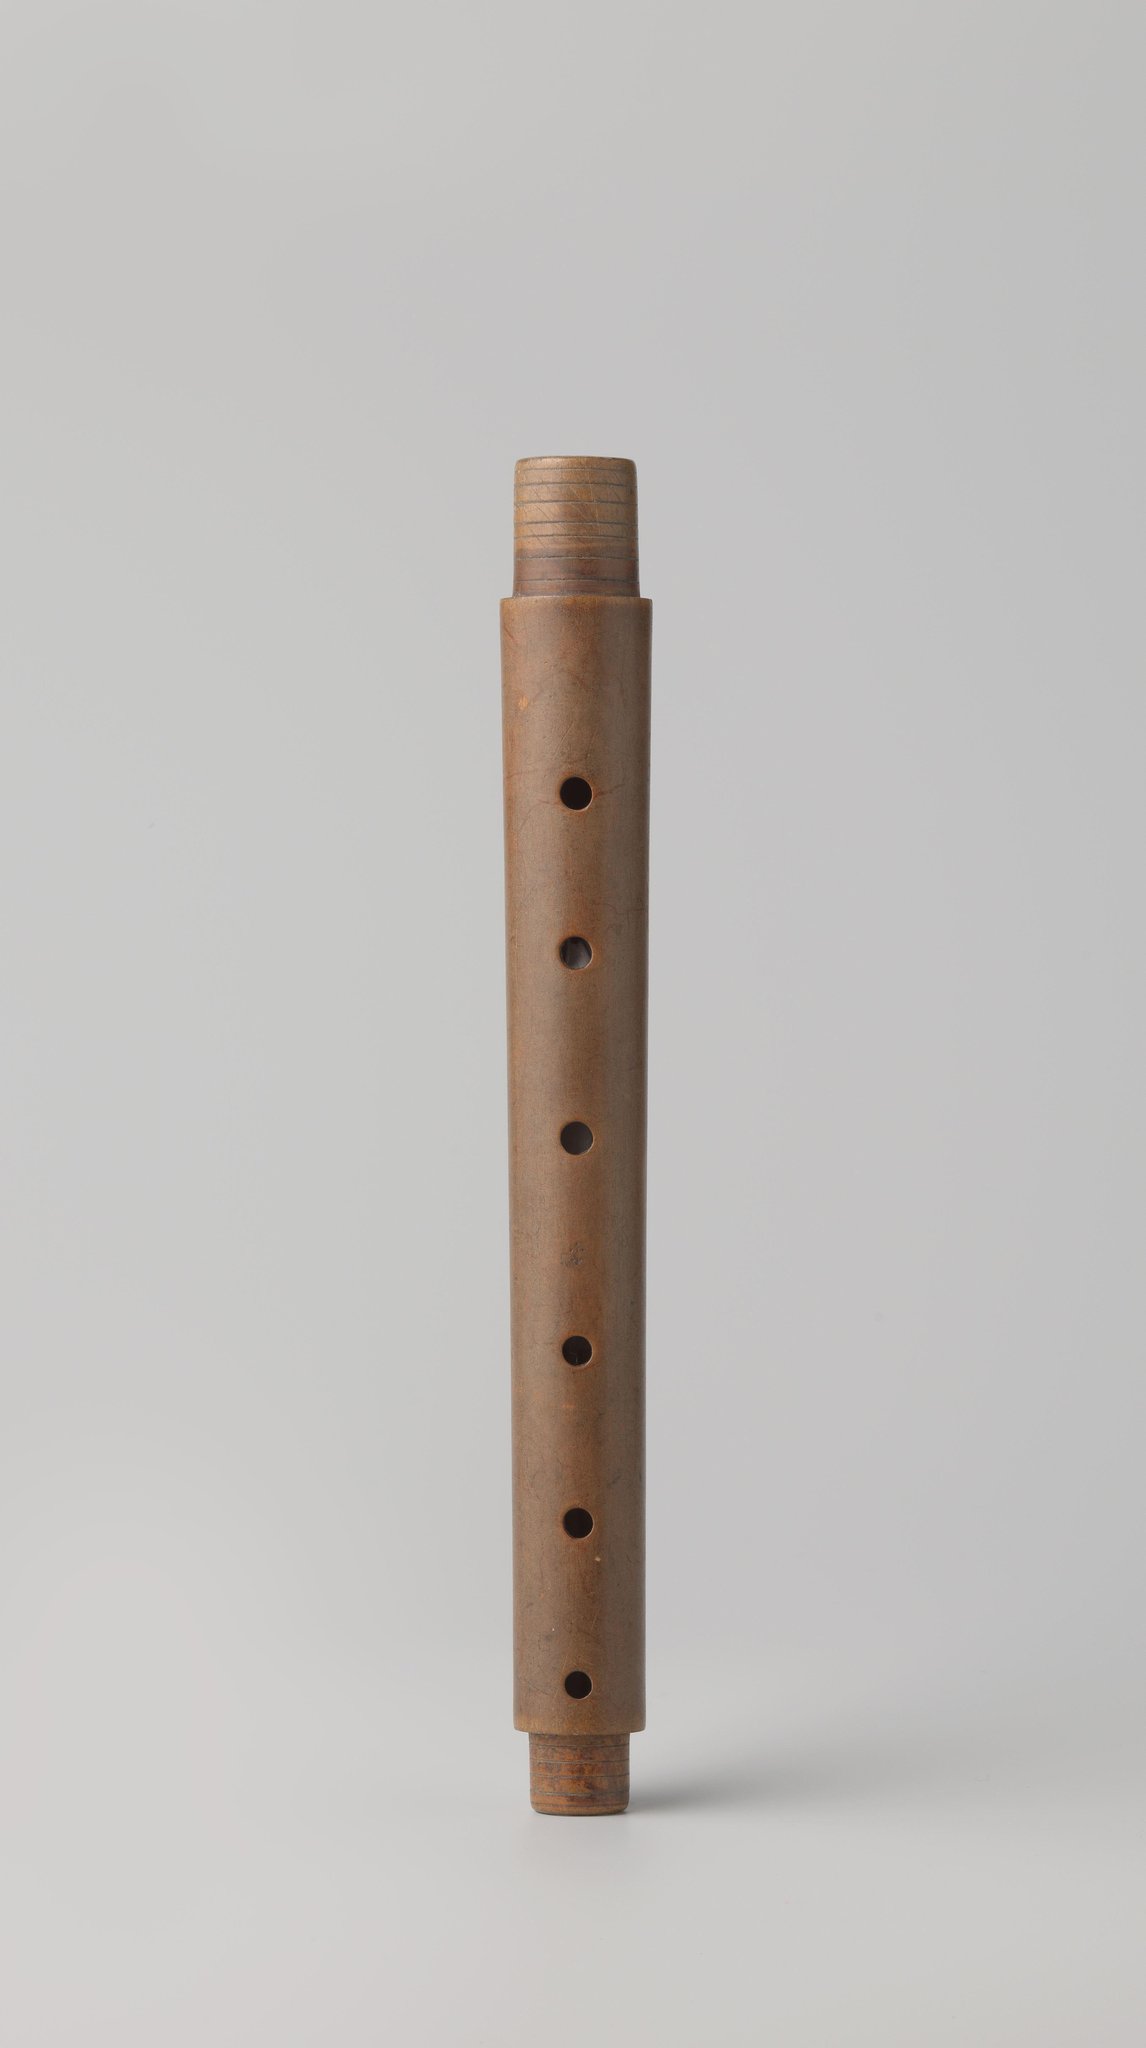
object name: musical instrument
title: Alto recorder (middle joint)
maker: jan steenbergen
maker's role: musical instrument maker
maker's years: 1676-1730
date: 1700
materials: wood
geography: amsterdam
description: Middendeel altblokfluit, vervaardigd van esdoornhout